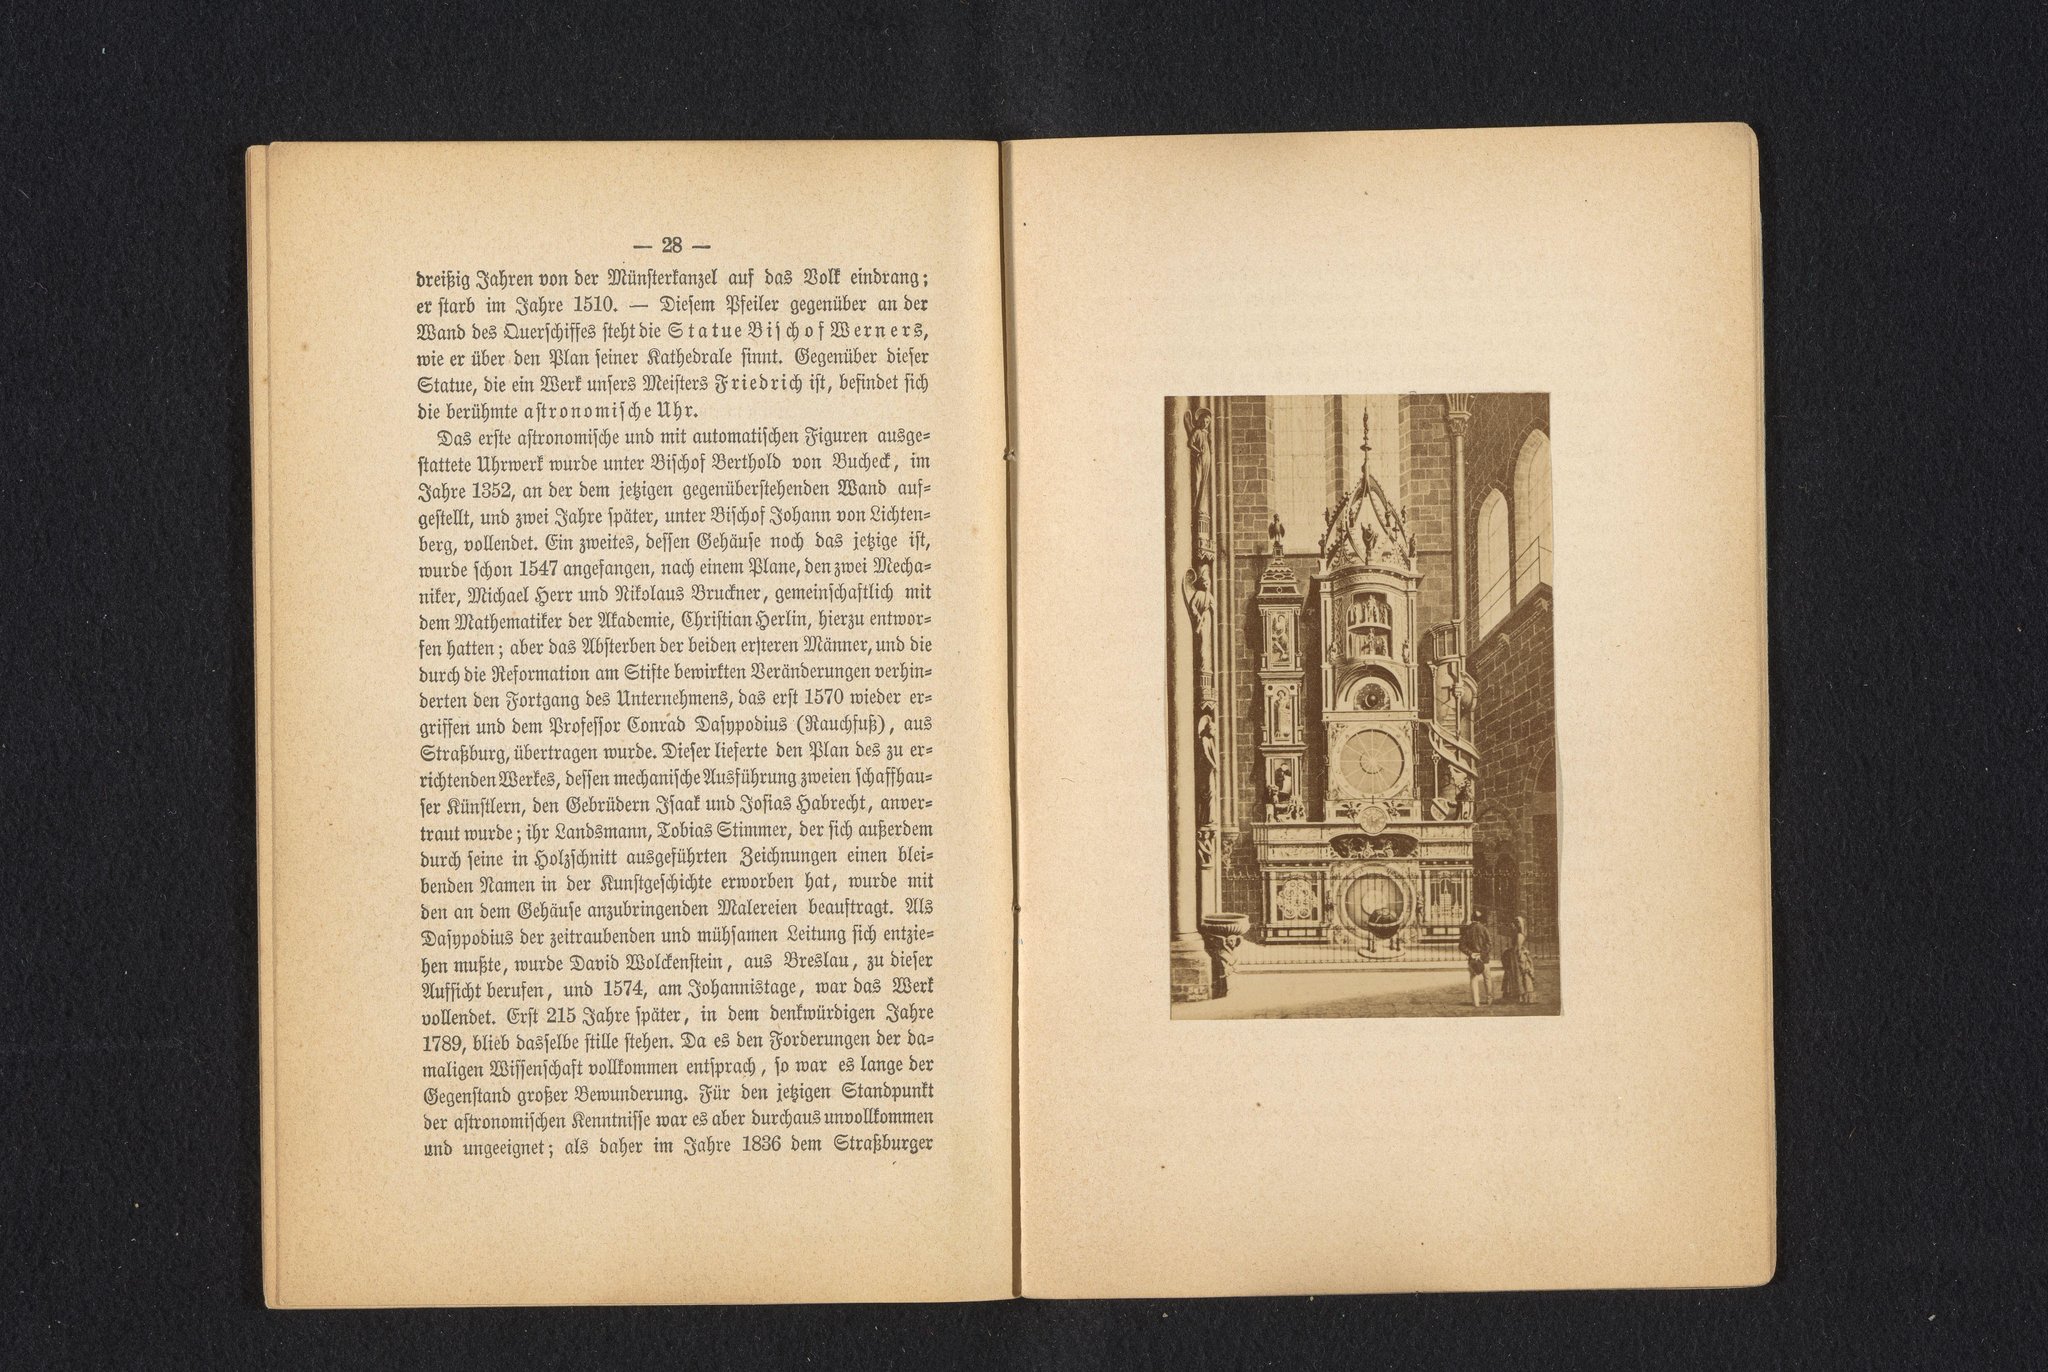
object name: page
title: Gezicht op het astronomisch uurwerk van de Kathedraal van Straatsburg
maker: Anonymous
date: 1882-1887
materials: photographic support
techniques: albumen print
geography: straatsburg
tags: clock